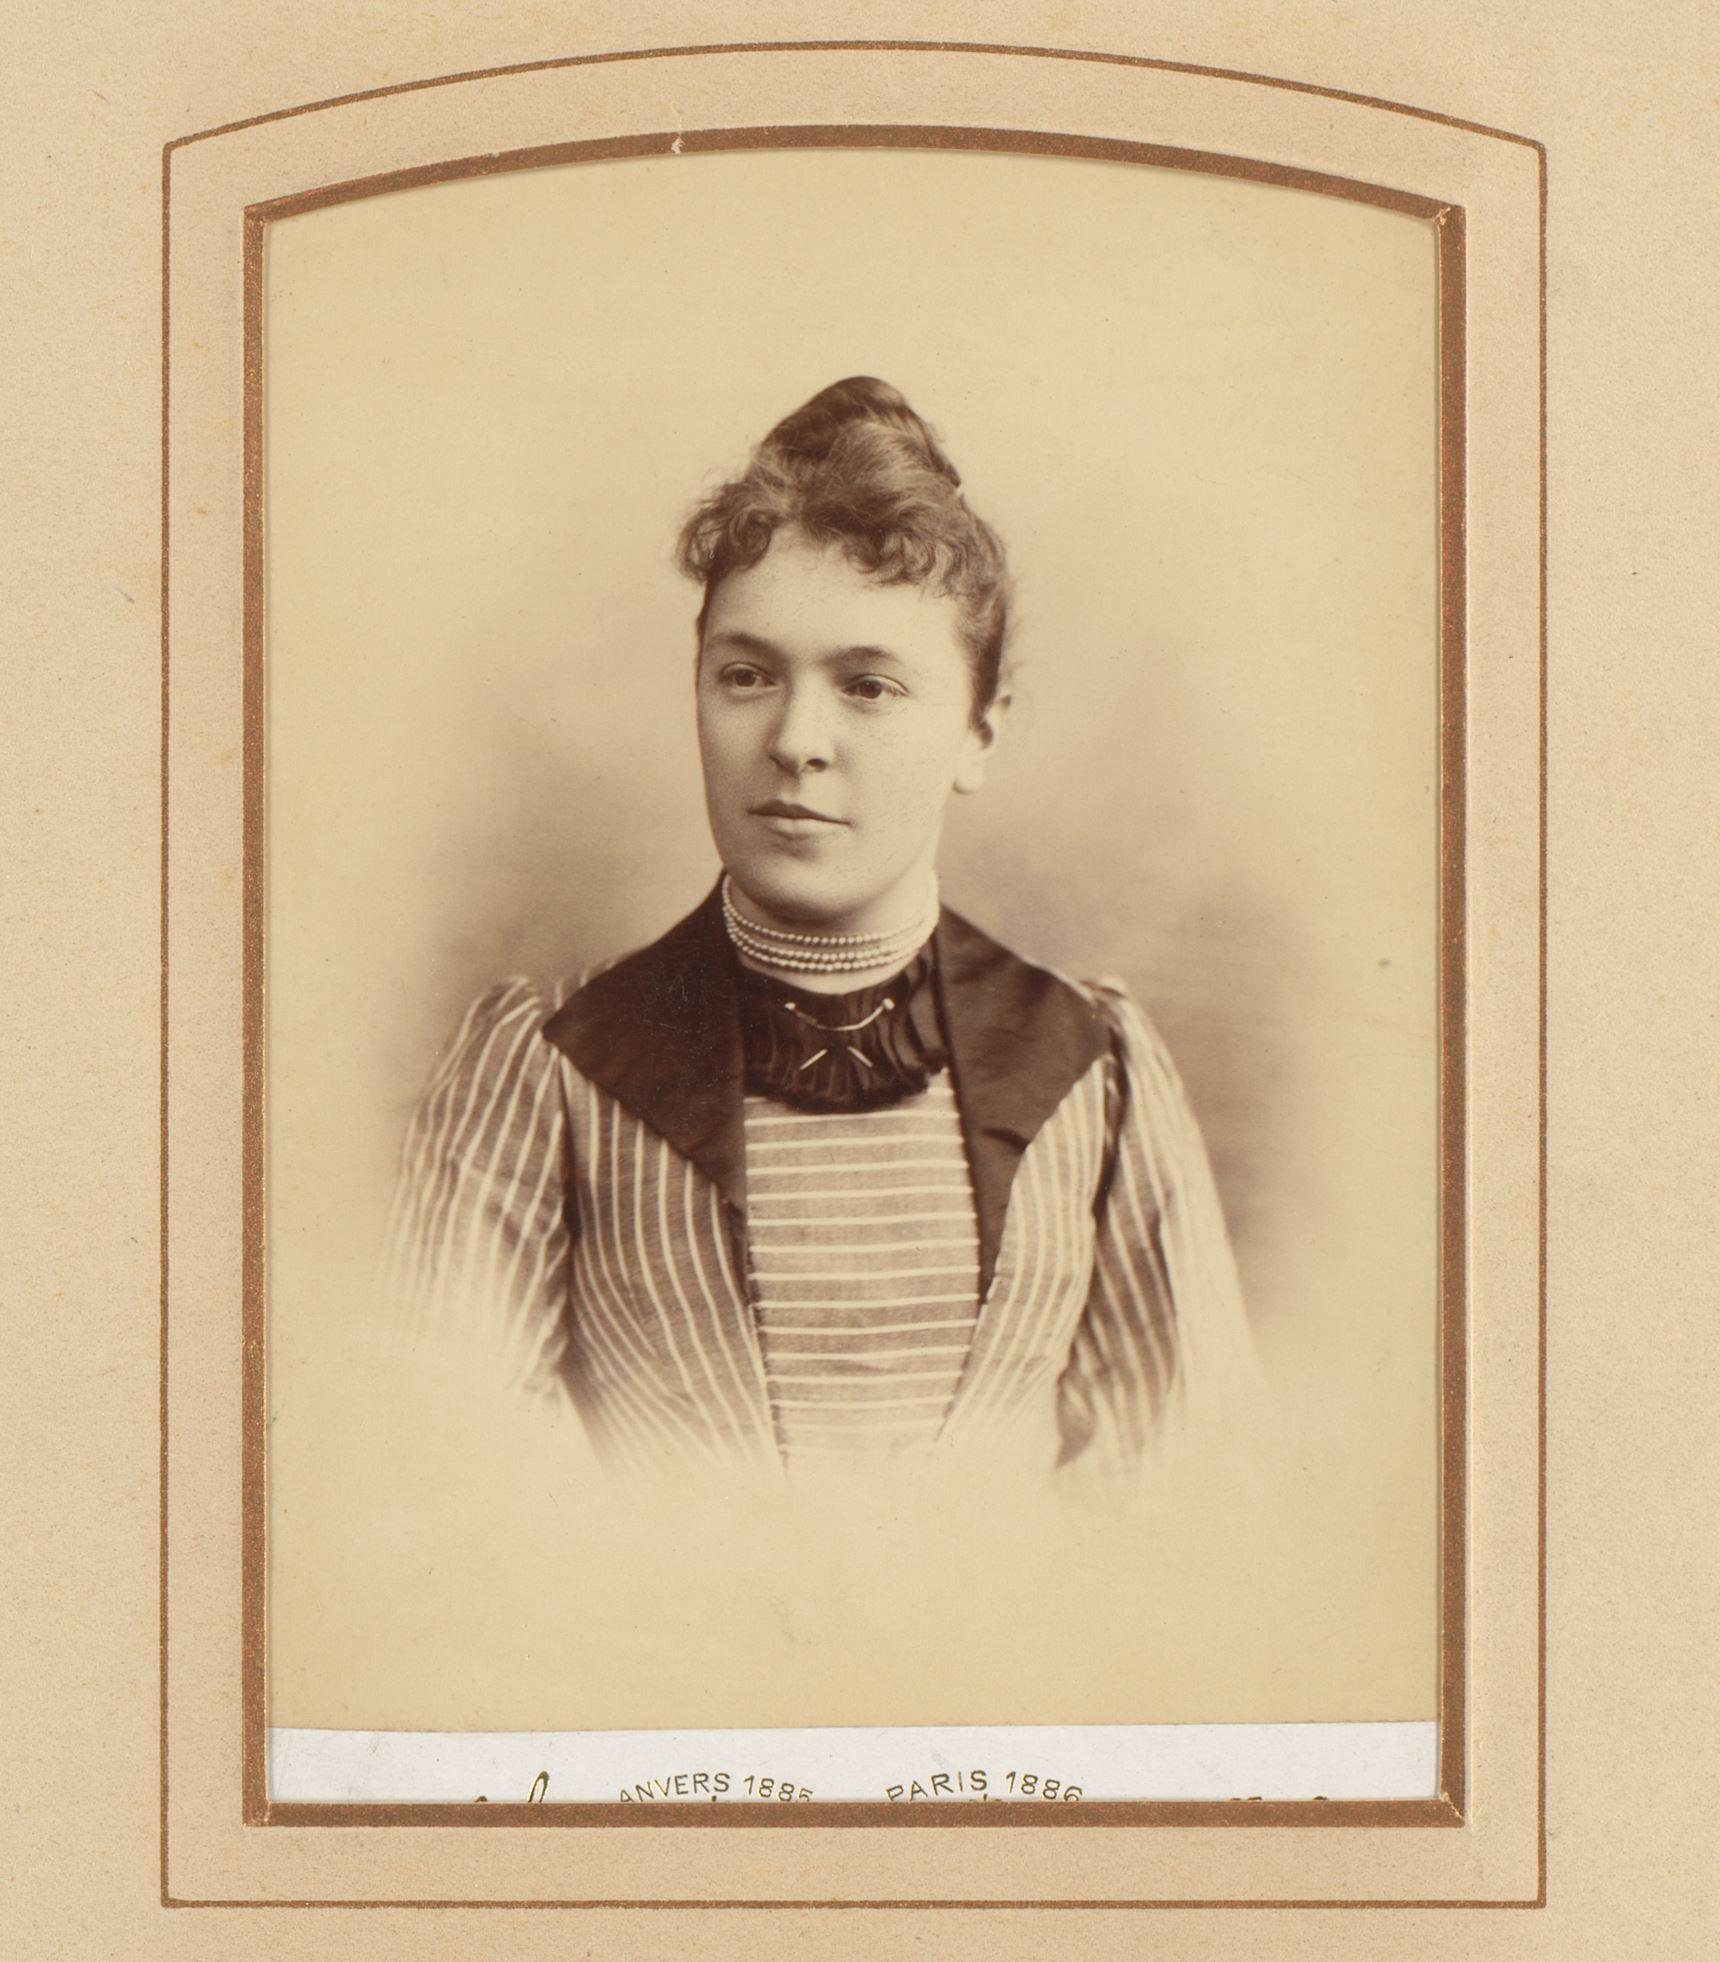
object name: cabinet photograph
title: Portret van een jonge vrouw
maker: adolphe zimmermans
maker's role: fotograaf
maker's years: 1858-1922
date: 1886-1900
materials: cardboard, photographic support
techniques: albumen print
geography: the hague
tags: historical persons - bb - woman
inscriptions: inscription: ‘Adolphe/ Anvers 1885/ Paris 1886/ De Riemerstraat 21/ La Haye’